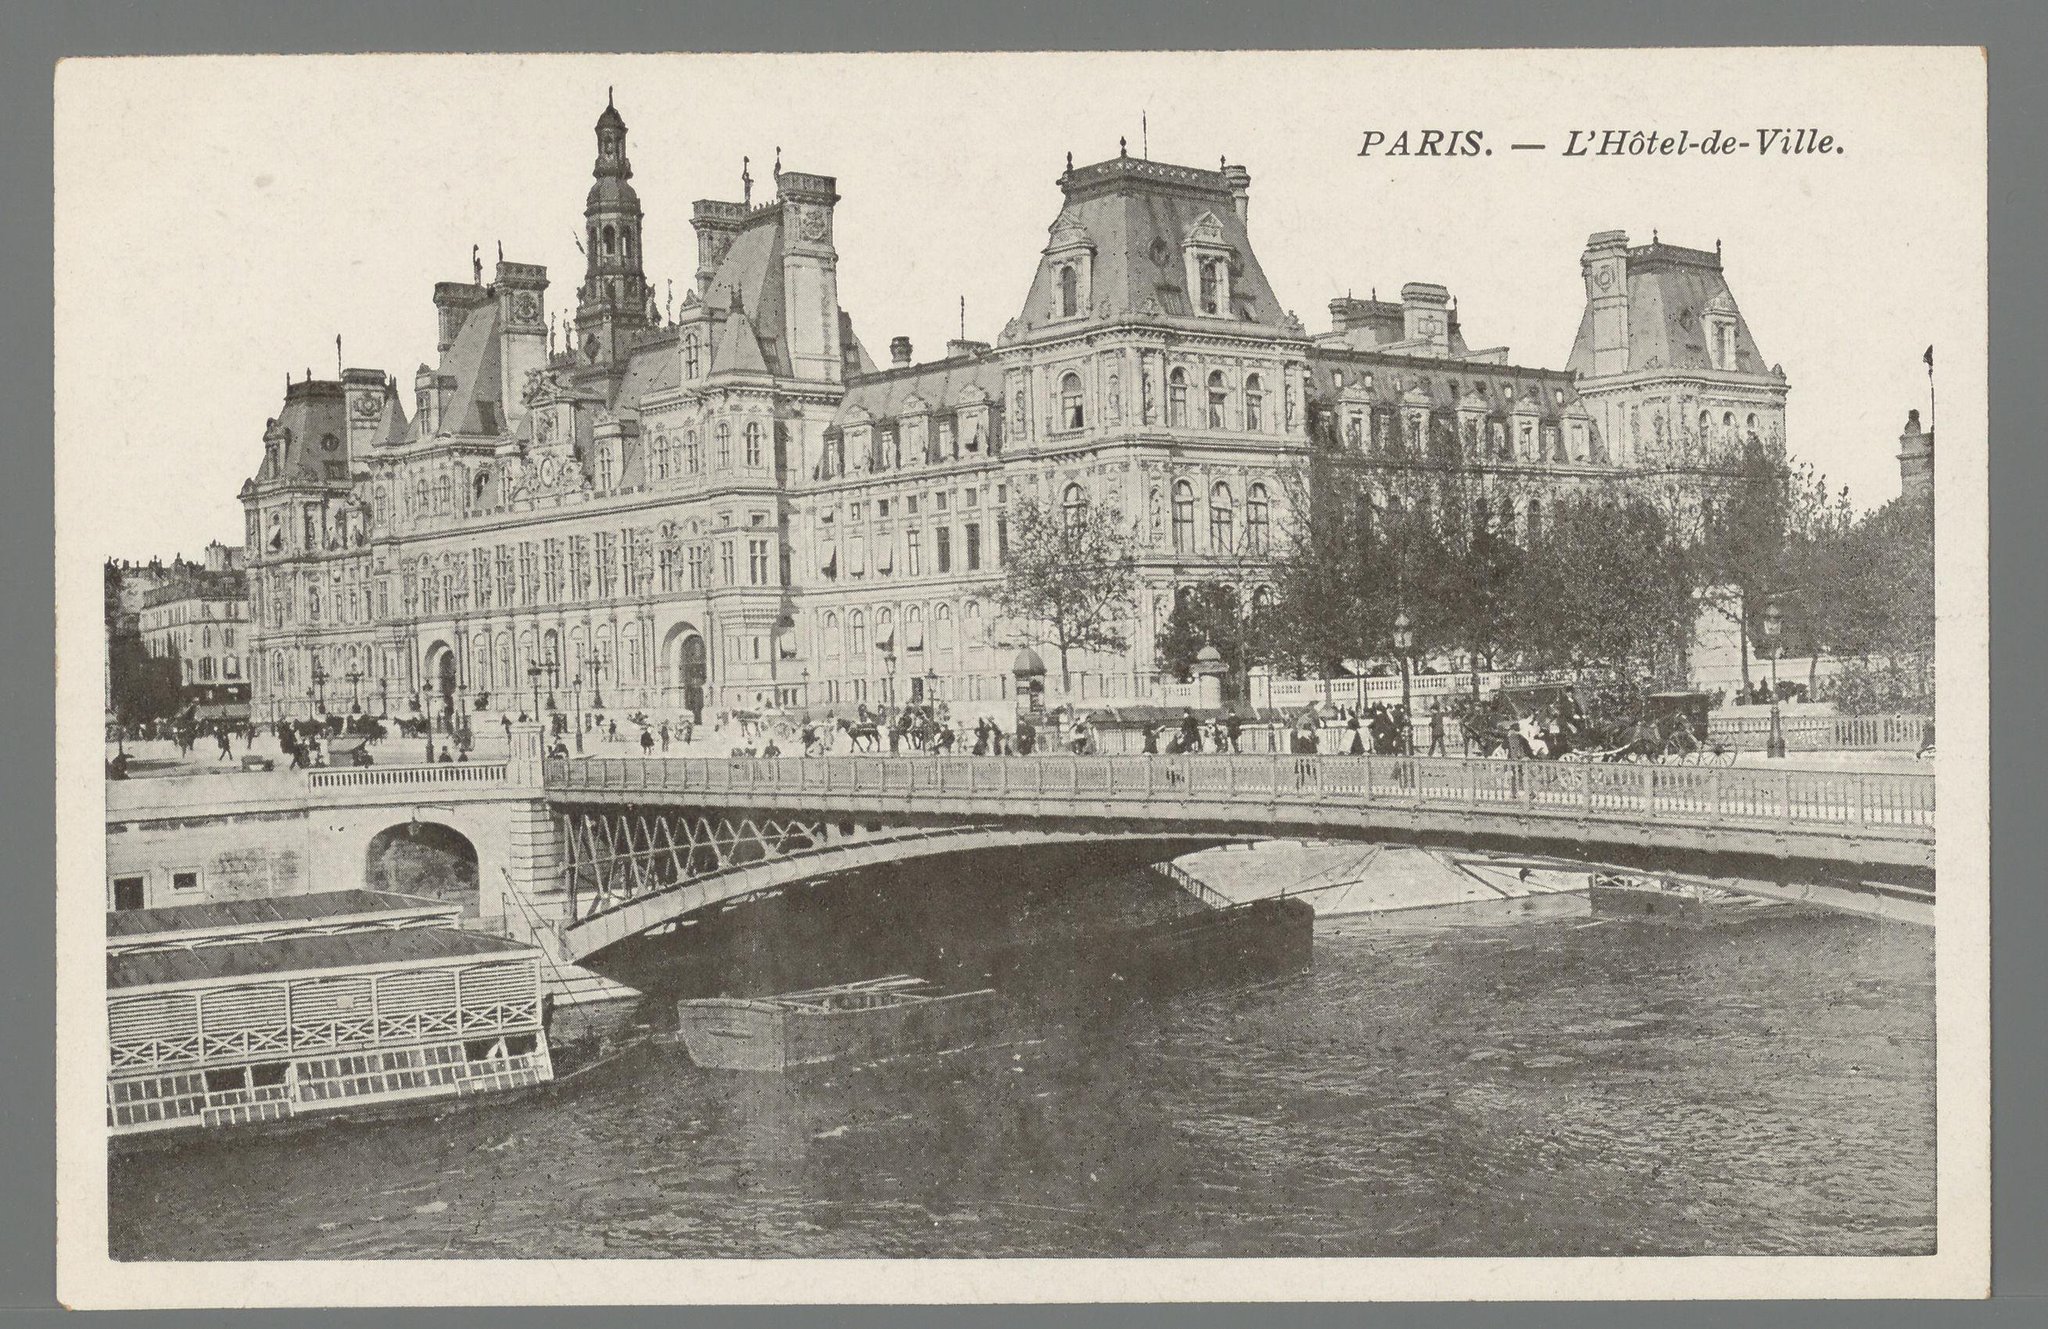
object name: photomechanical print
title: Paris. L'Hôtel-de-Ville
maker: Anonymous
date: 1904-1906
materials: cardboard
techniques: autotype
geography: paris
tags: river, townhall, city-view, and landscape with man-made constructions (+ city(-scape) with figures, staffage)